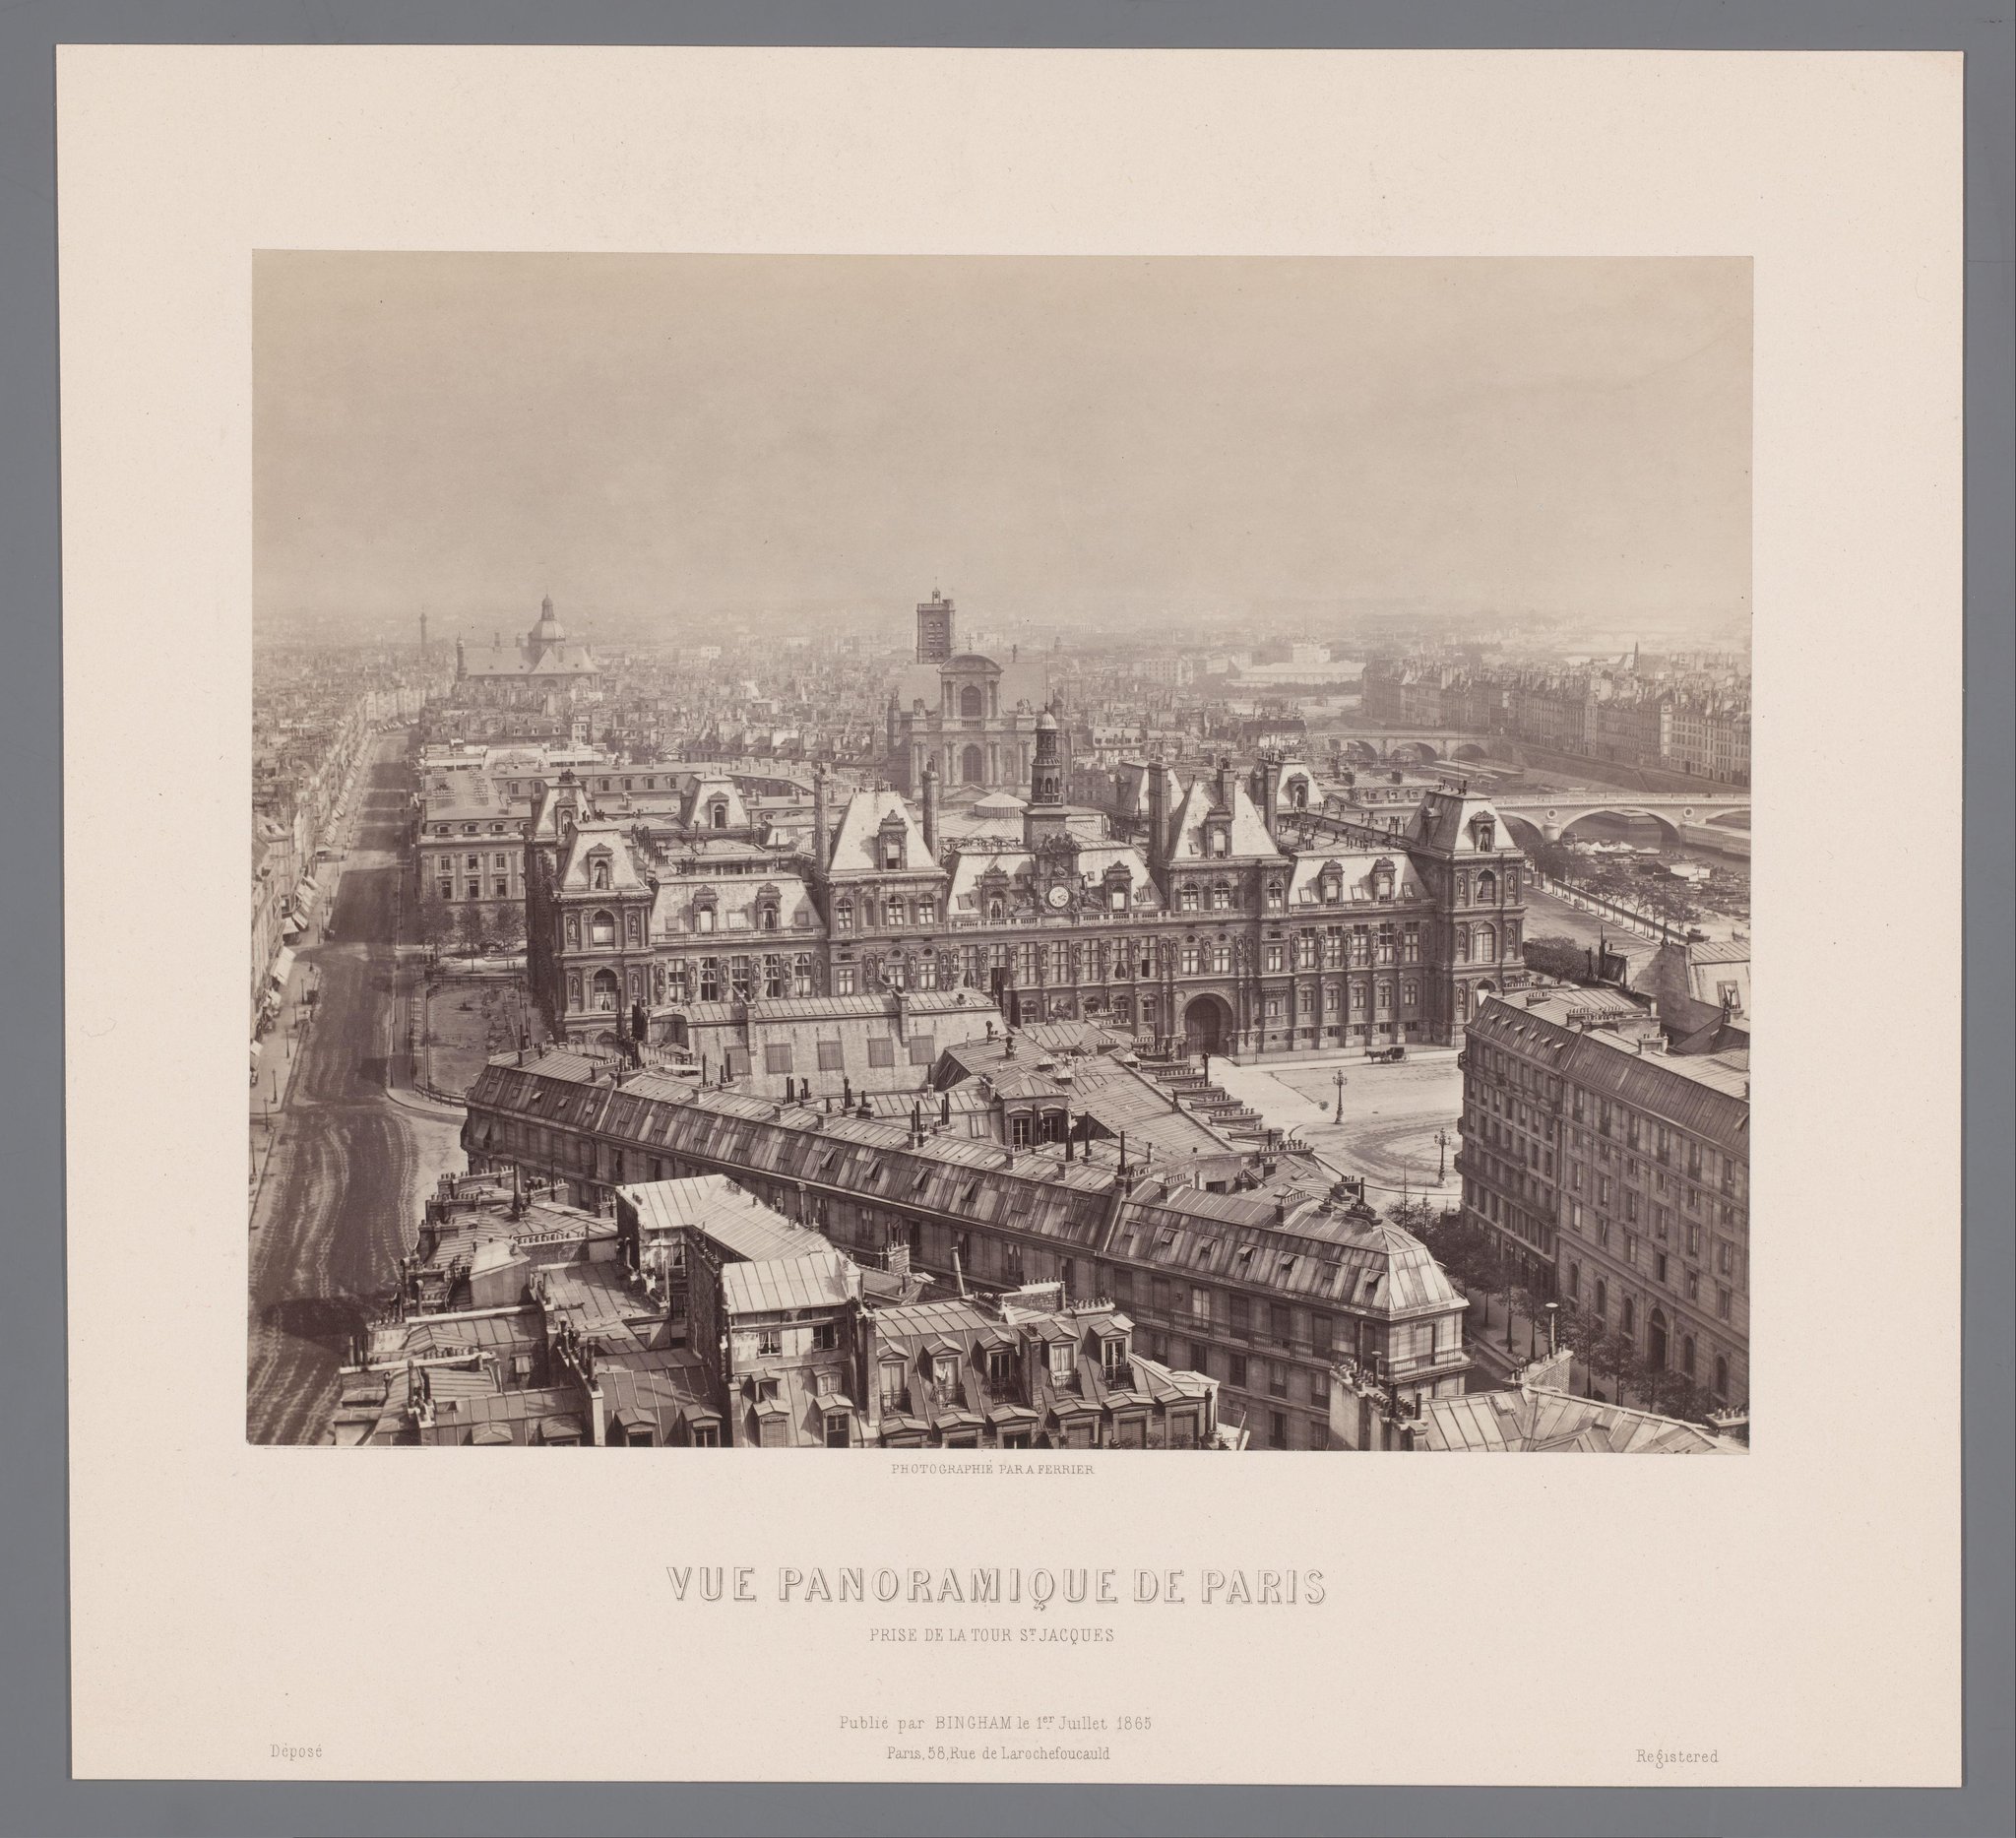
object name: photograph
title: View of Paris from Tour St. Jacques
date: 1865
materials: cardboard, photographic support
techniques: albumen print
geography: paris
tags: city-view in general; 'veduta' - ii - ideal city, paris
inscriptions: address: ‘Paris, 58, Rue de Larochefoucauld’, inscription: ‘Déposé/ Registered’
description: Ferrier climbed to the top of the tower and looked down at the ever-sprawling metropolis. Only in photography can a view of a city unfold with such precision and in such detail. The combination of a large negative, a high-quality lens, and the shiny albumen paper on which he printed the image yielded a pinpoint-sharp and breathtaking view.